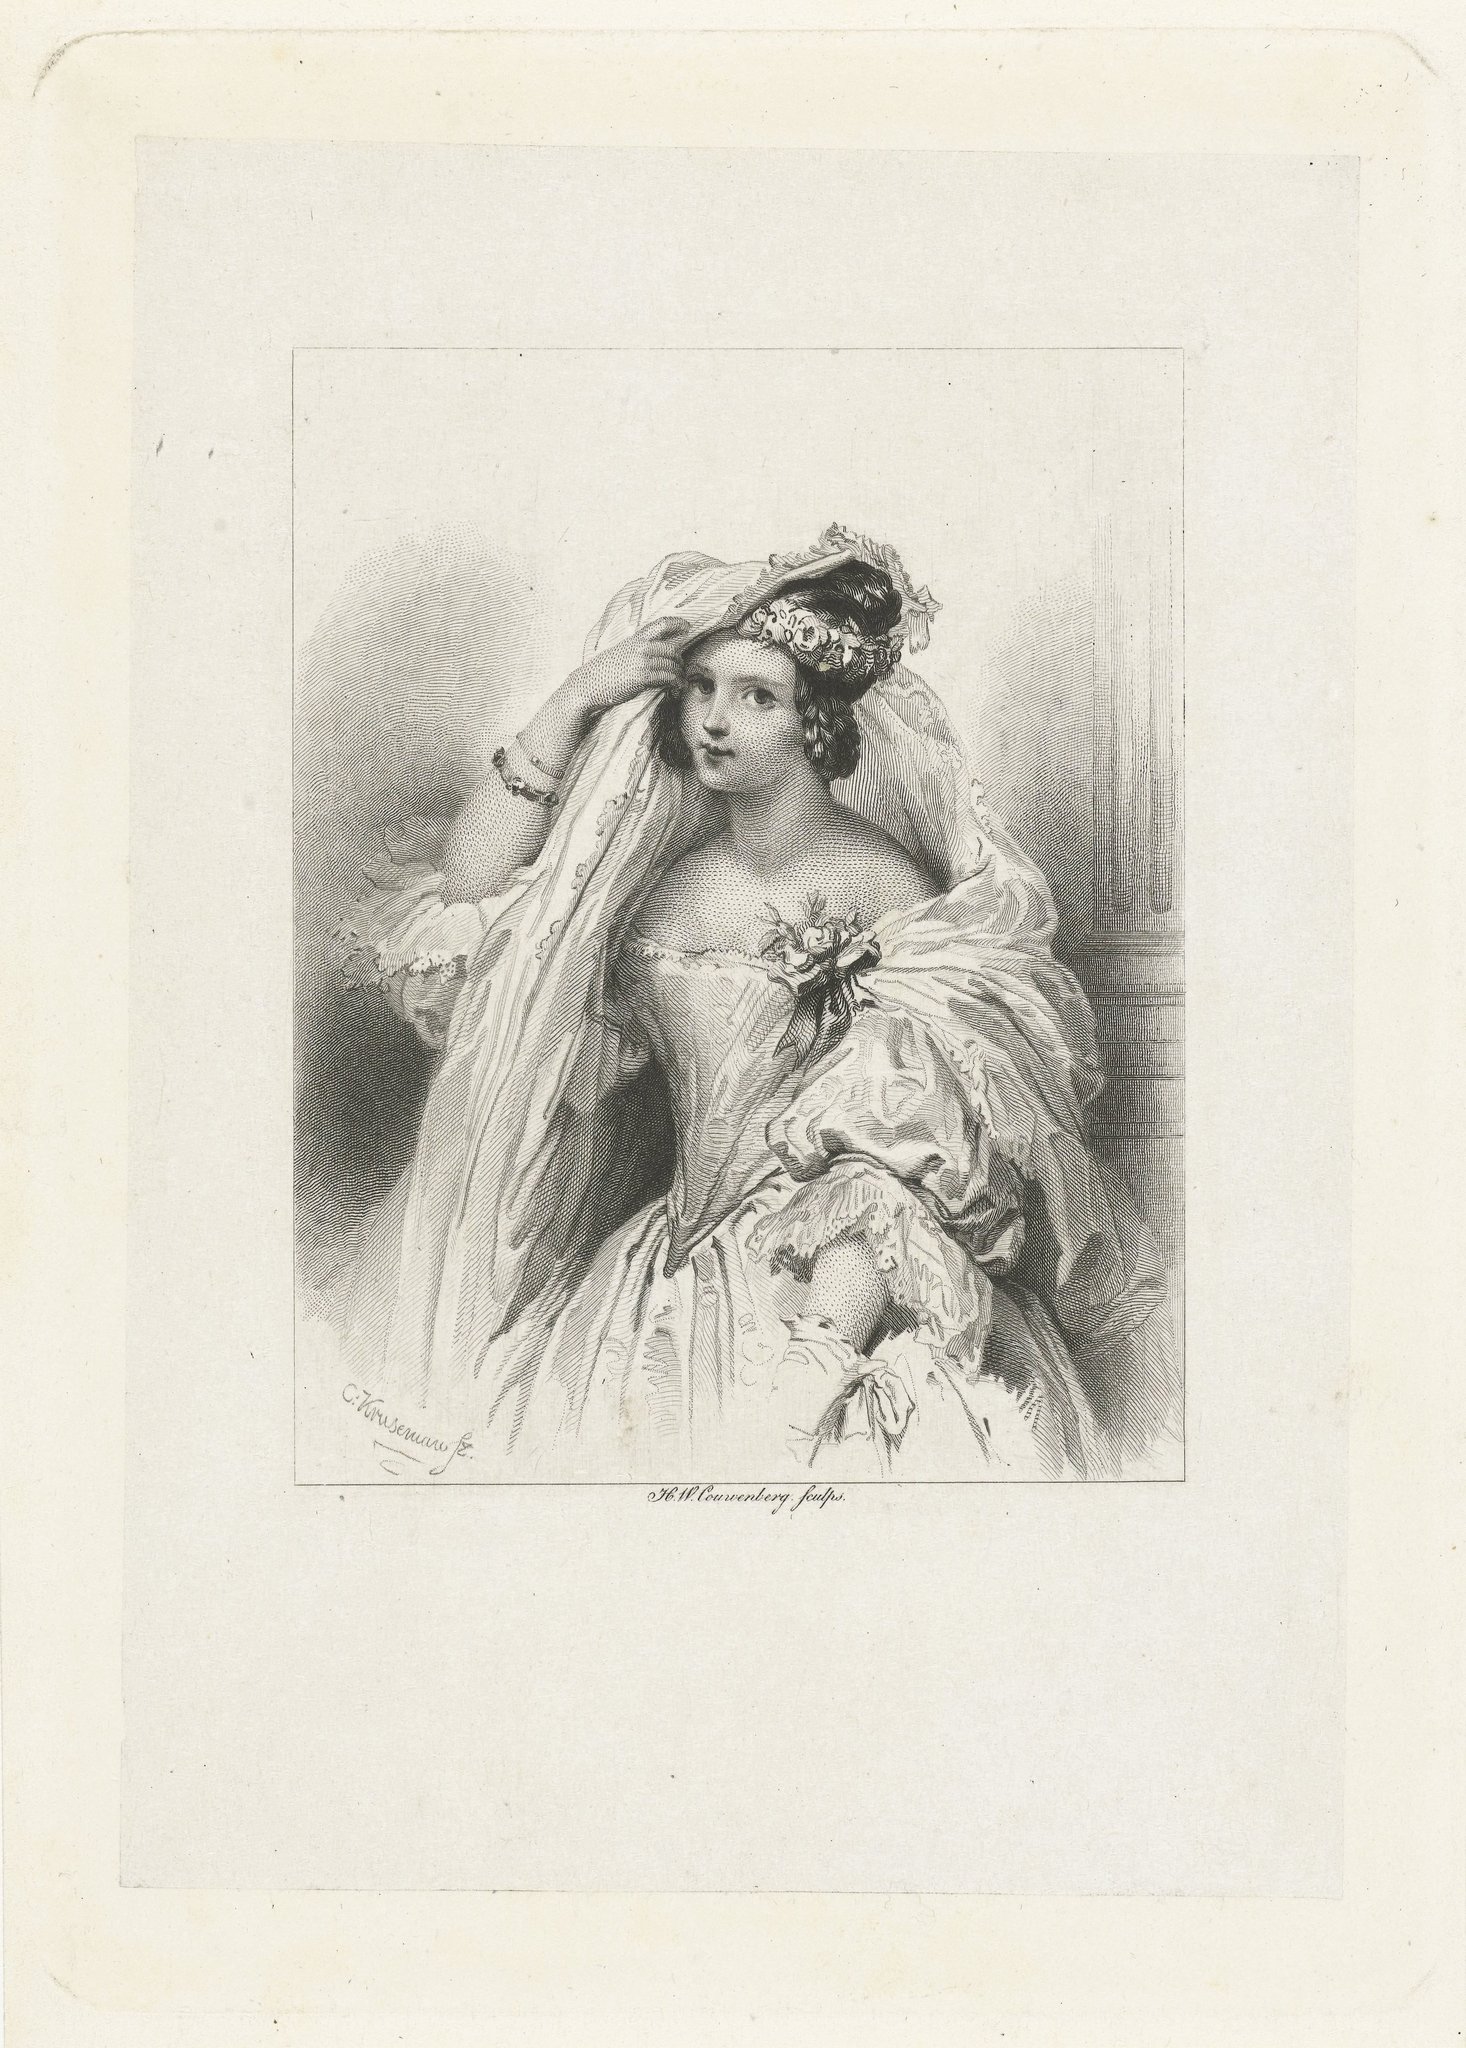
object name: book illustration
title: Portret van een jonge dame genaamd Lilia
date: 1838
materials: paper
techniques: engraving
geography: amsterdam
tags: female literary characters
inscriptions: collector's mark: Lugt 2228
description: Illustratie voor: Tesselschade. Jaarboekje voor 1839. Amsterdam: H. Frijlink, [1838].